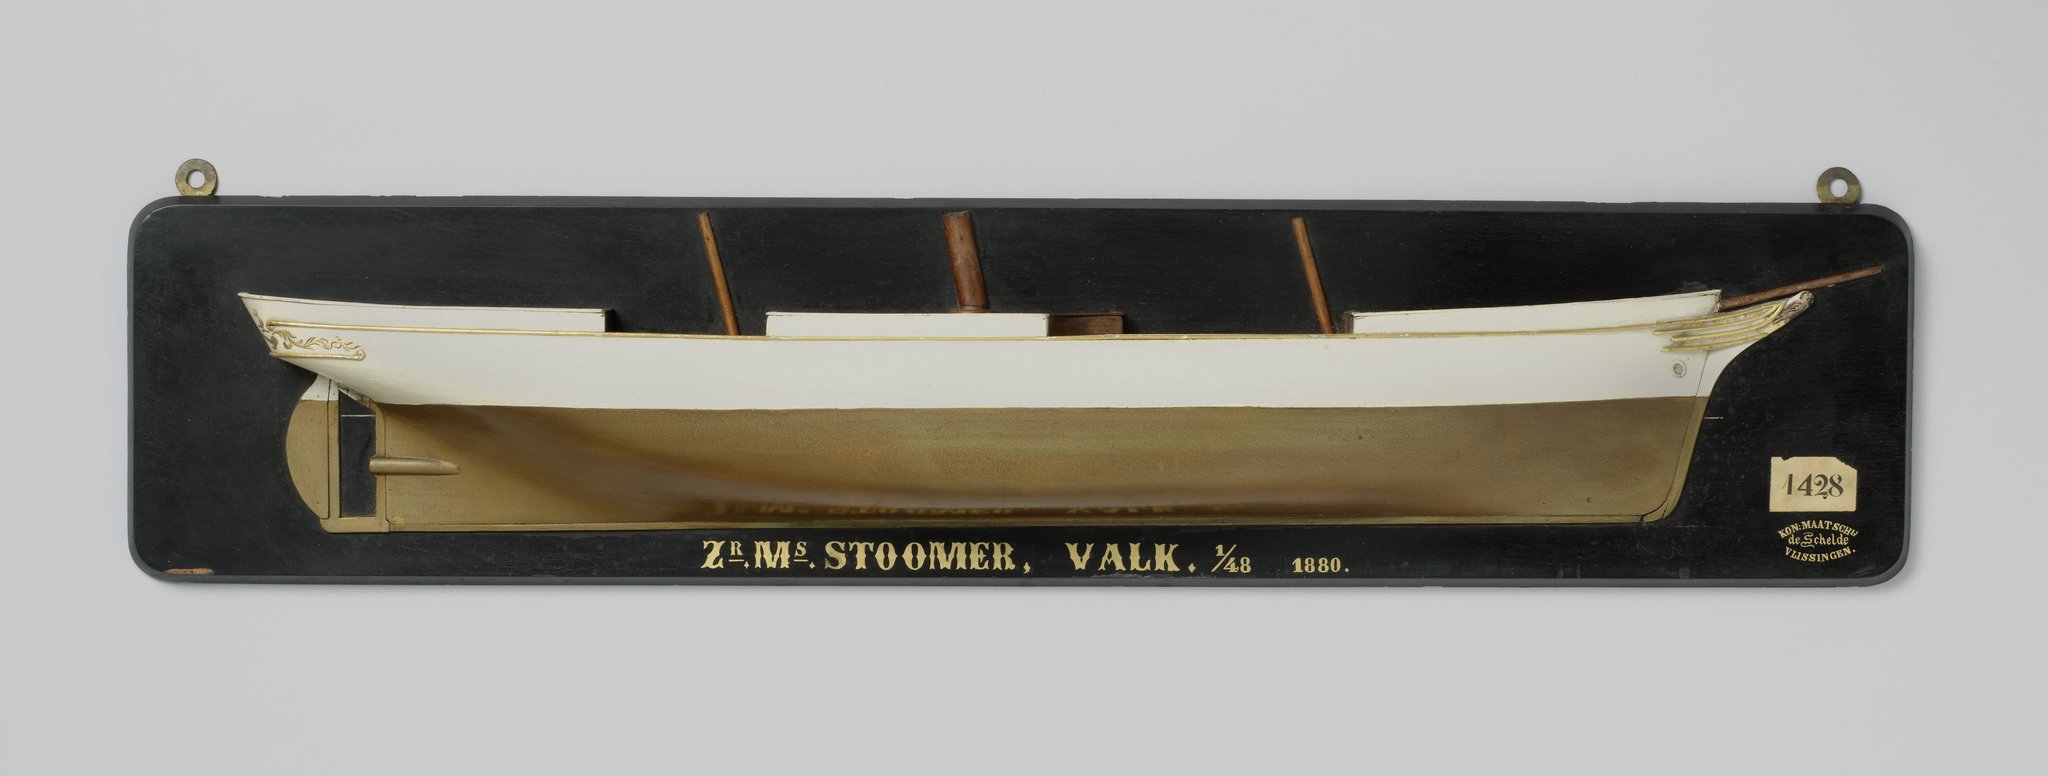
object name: builder's model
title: Half Model of a Screw Steamer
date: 1880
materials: wood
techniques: polychromy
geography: flushing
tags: valk (schip)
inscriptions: label, bottom right: ‘1428’ former inventory label, inscription, bottom right, in gold letters: ‘KON: MAATSCHIJ / de Schelde / VLISSINGEN.’, inscription, bottom centre, in gold letters: ‘Zr. Ms. STOOMER, VALK. 1/48 1880.’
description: Gepolychromeerd blokmodel (stuurboord) van een tweemast schroefstoomschip. Drie verhoogde dekken: bovencampnaje, middendeel en bakdek. Verticale, vallende steven, met galjoen met een valk. Elliptisch hek met bladmotieven en Rijkswapen; schroefraam met roer met ronde roerkoning (Amerikaans roer). Aan dek een terughellende schoorsteen. Zeeg naar beide einden oplopend. Rondspant met vlakke bodem. De mast hellen aanzienlijk terug. Schaal 1:48 (schaal op model).